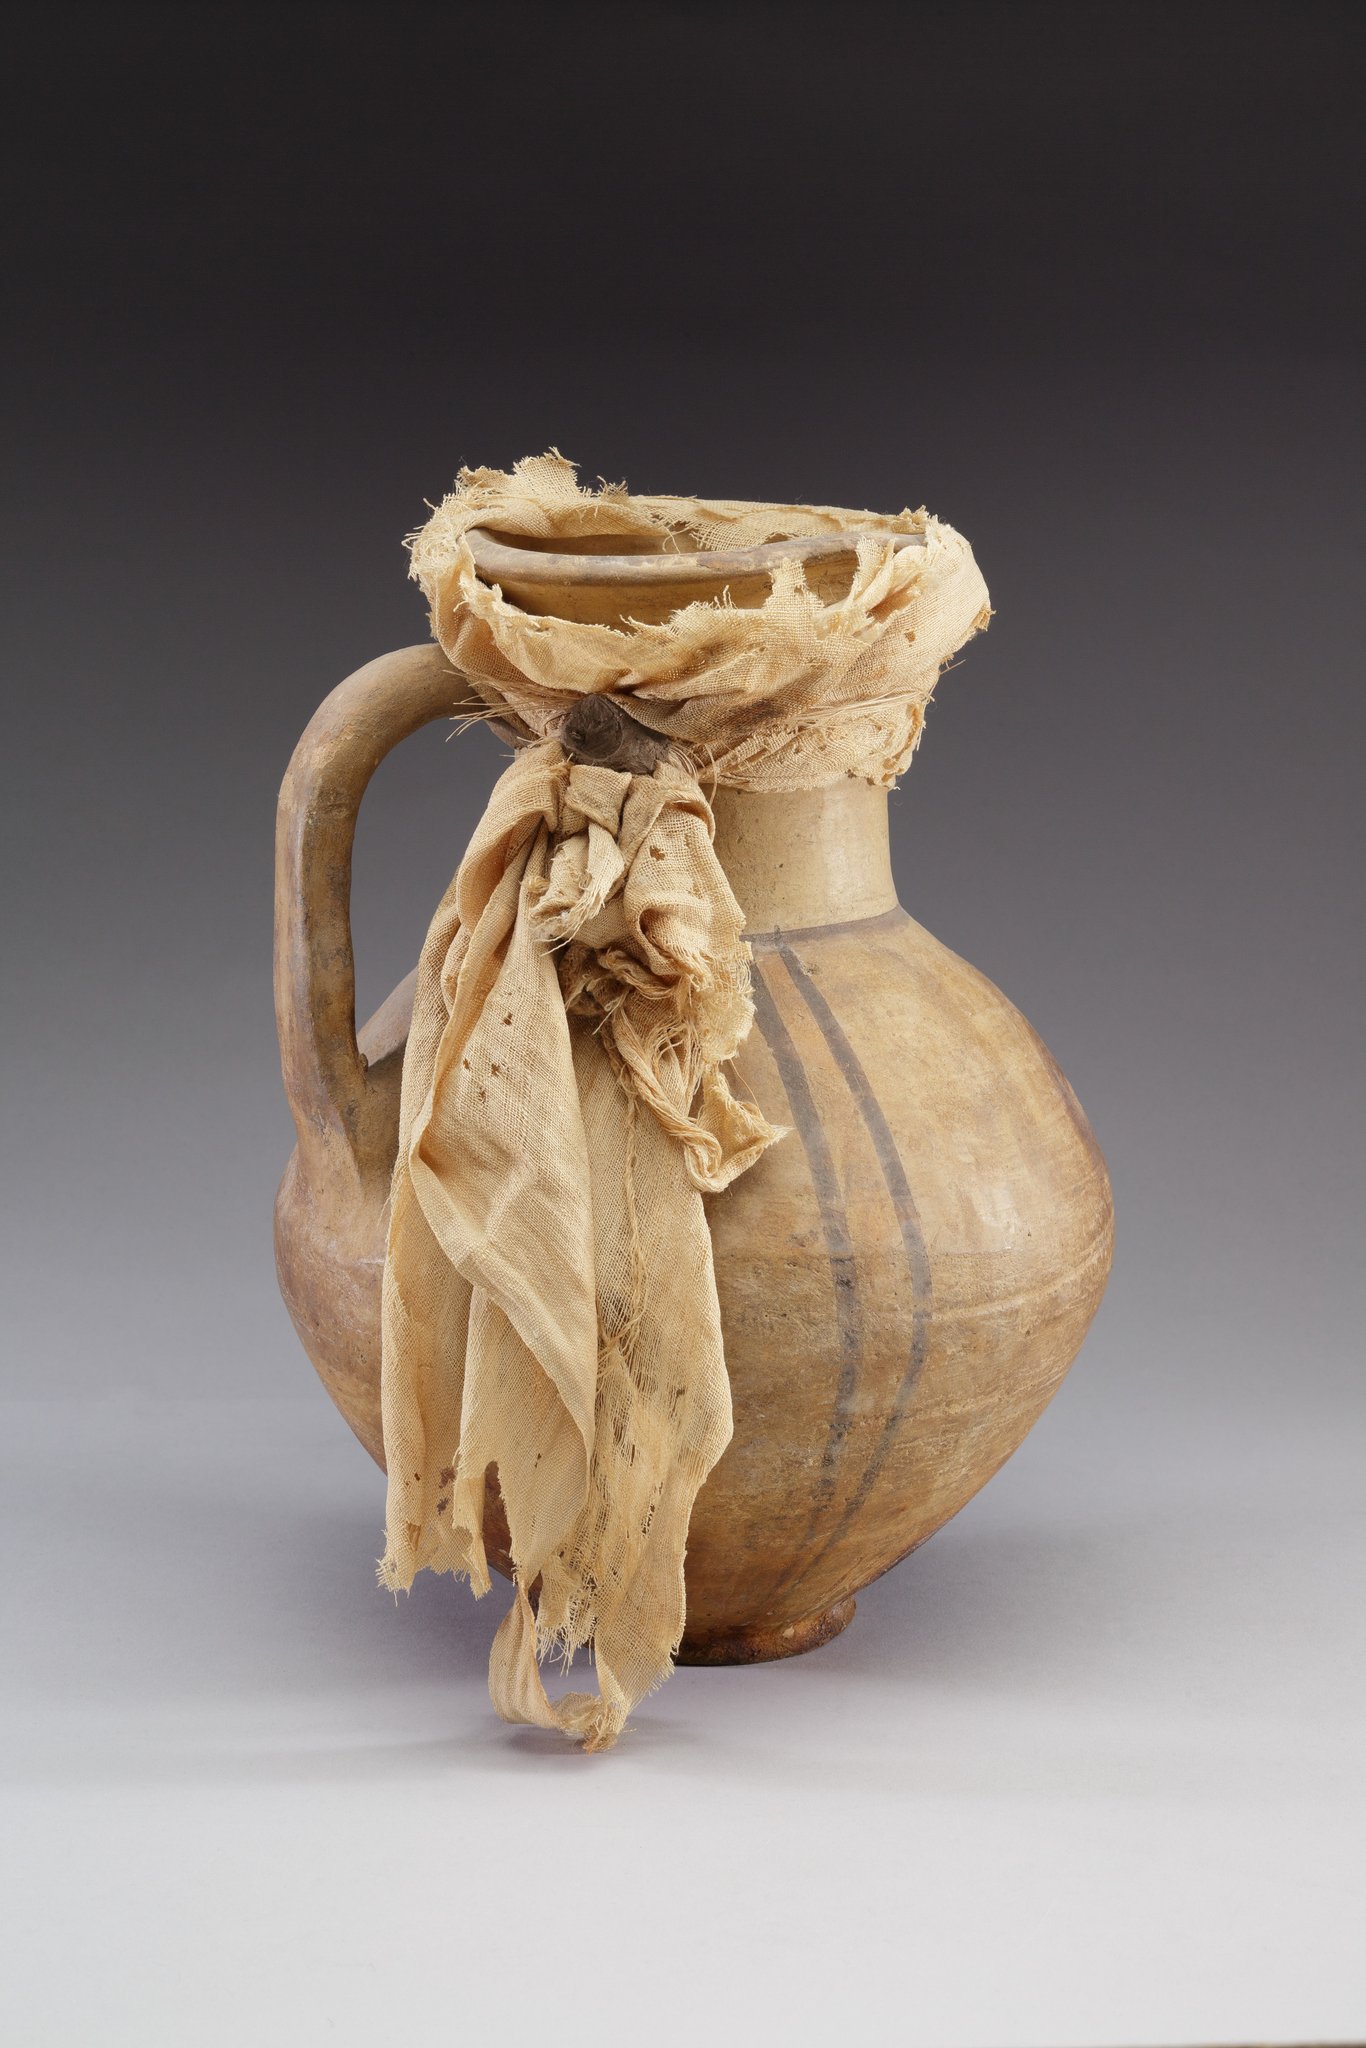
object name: jug, cloth, mud sealing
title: Painted Wide-Mouthed Jug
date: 1479-1458 BCE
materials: linen, mud, paint, pottery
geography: egypt